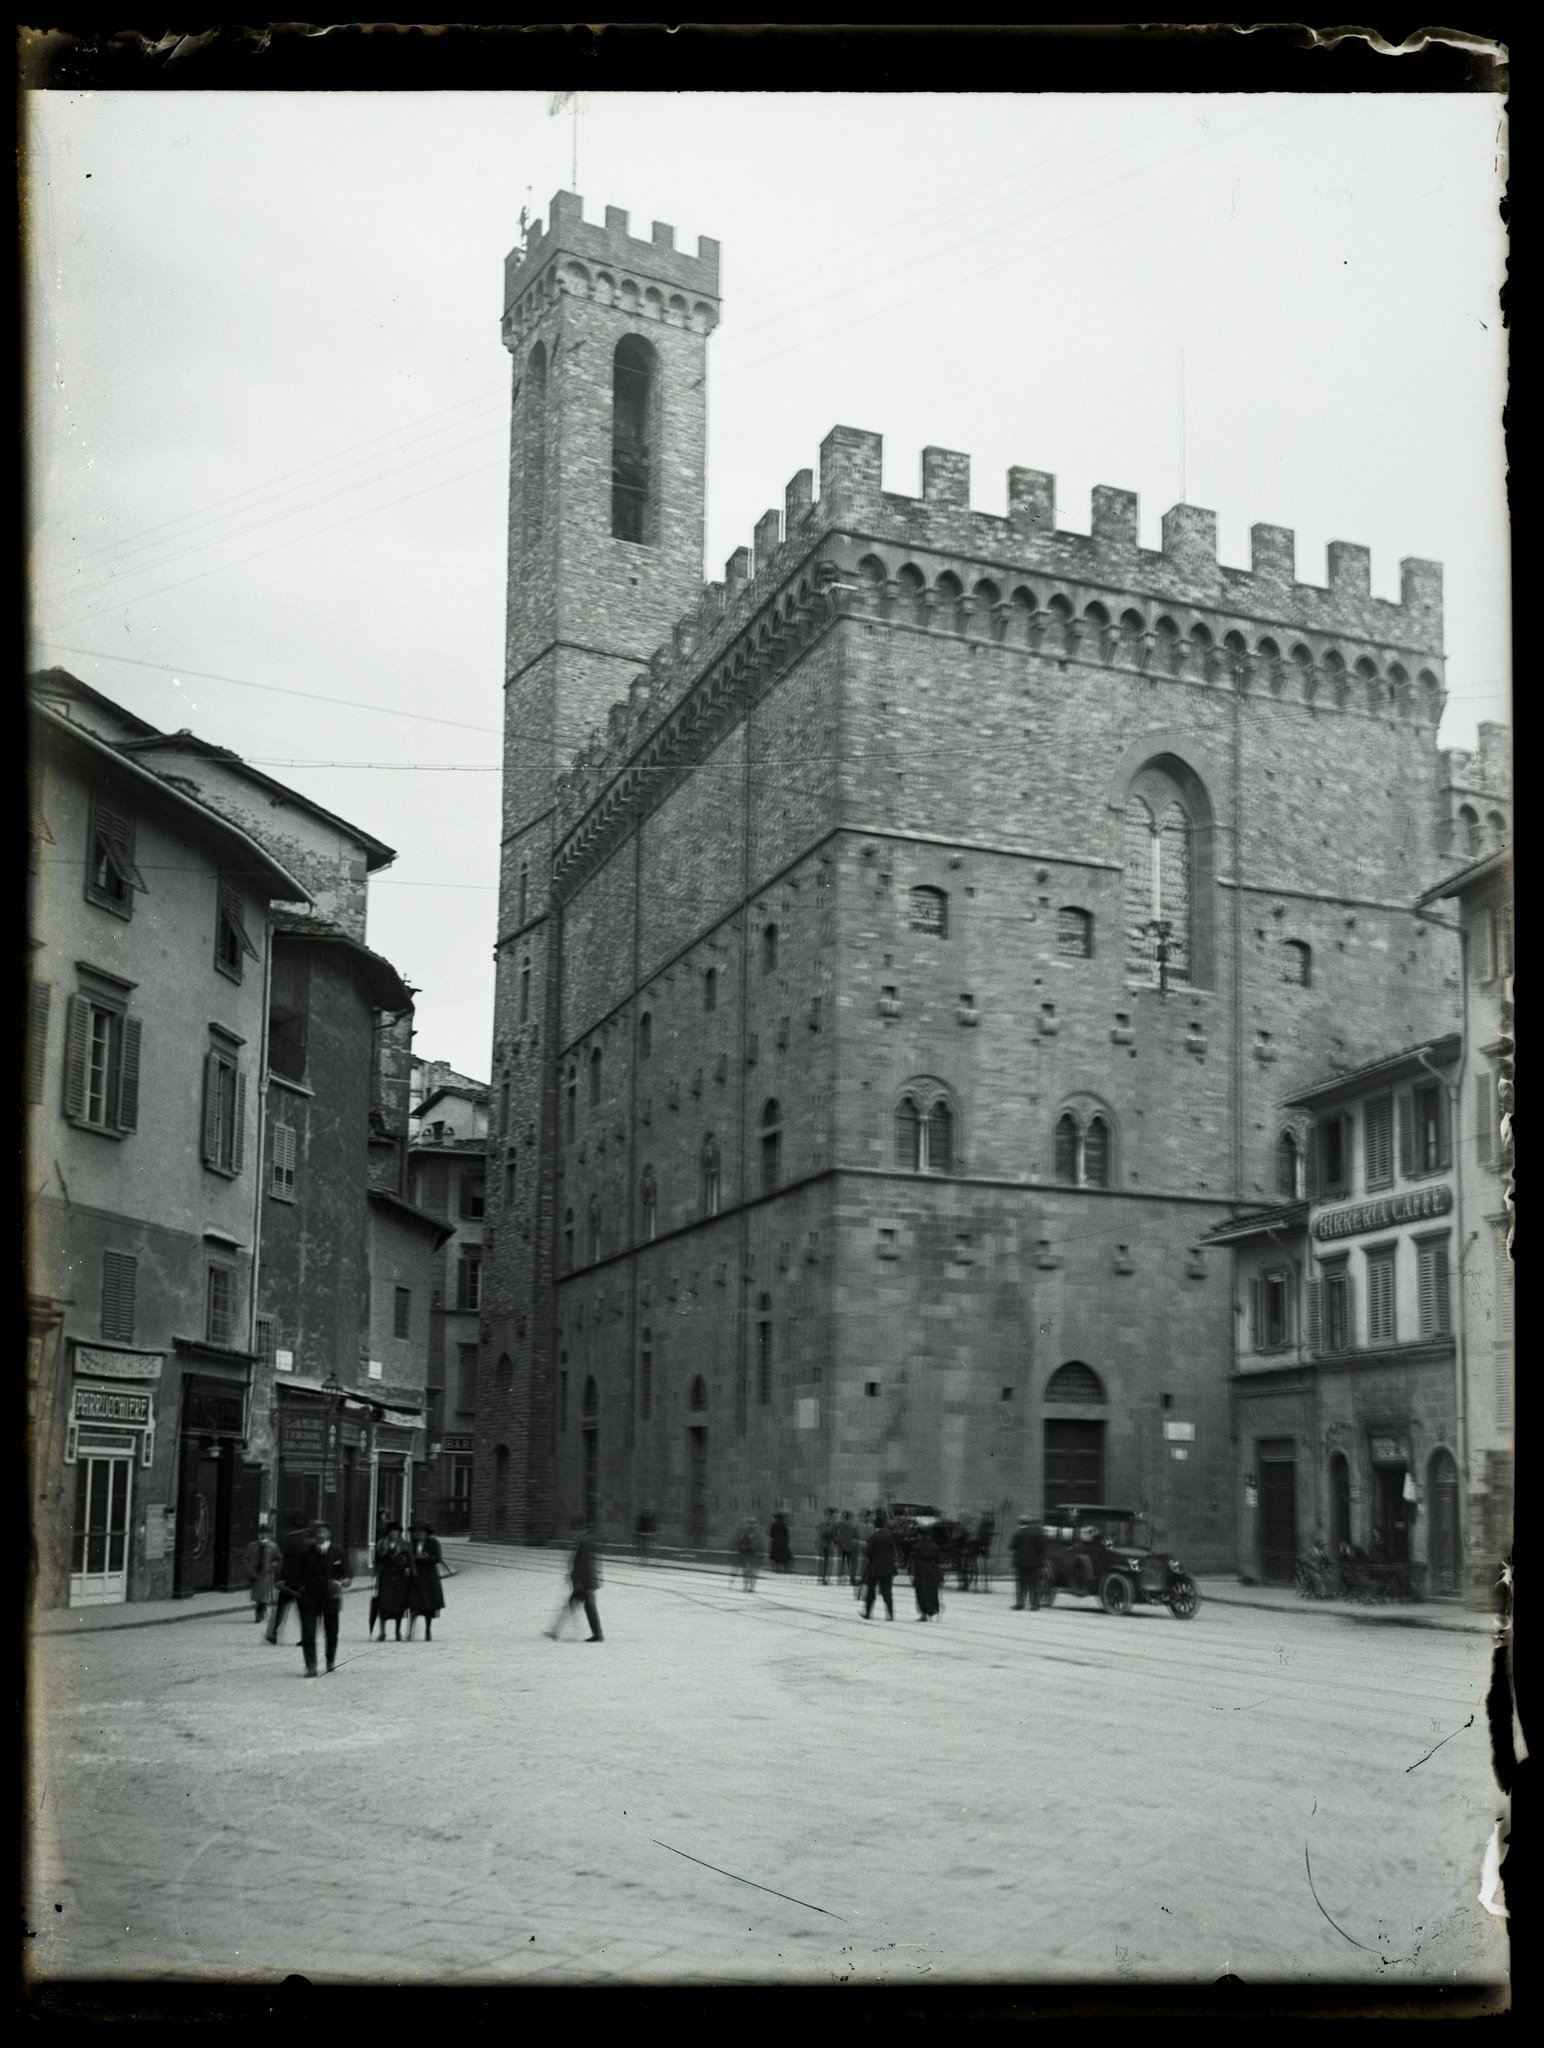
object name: glasnegatief, glasplaatnegatief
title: Palazzo del Bargello te Florence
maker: Anonymous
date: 1907-1935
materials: glass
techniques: gelatin glass negative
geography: florence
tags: palace, street